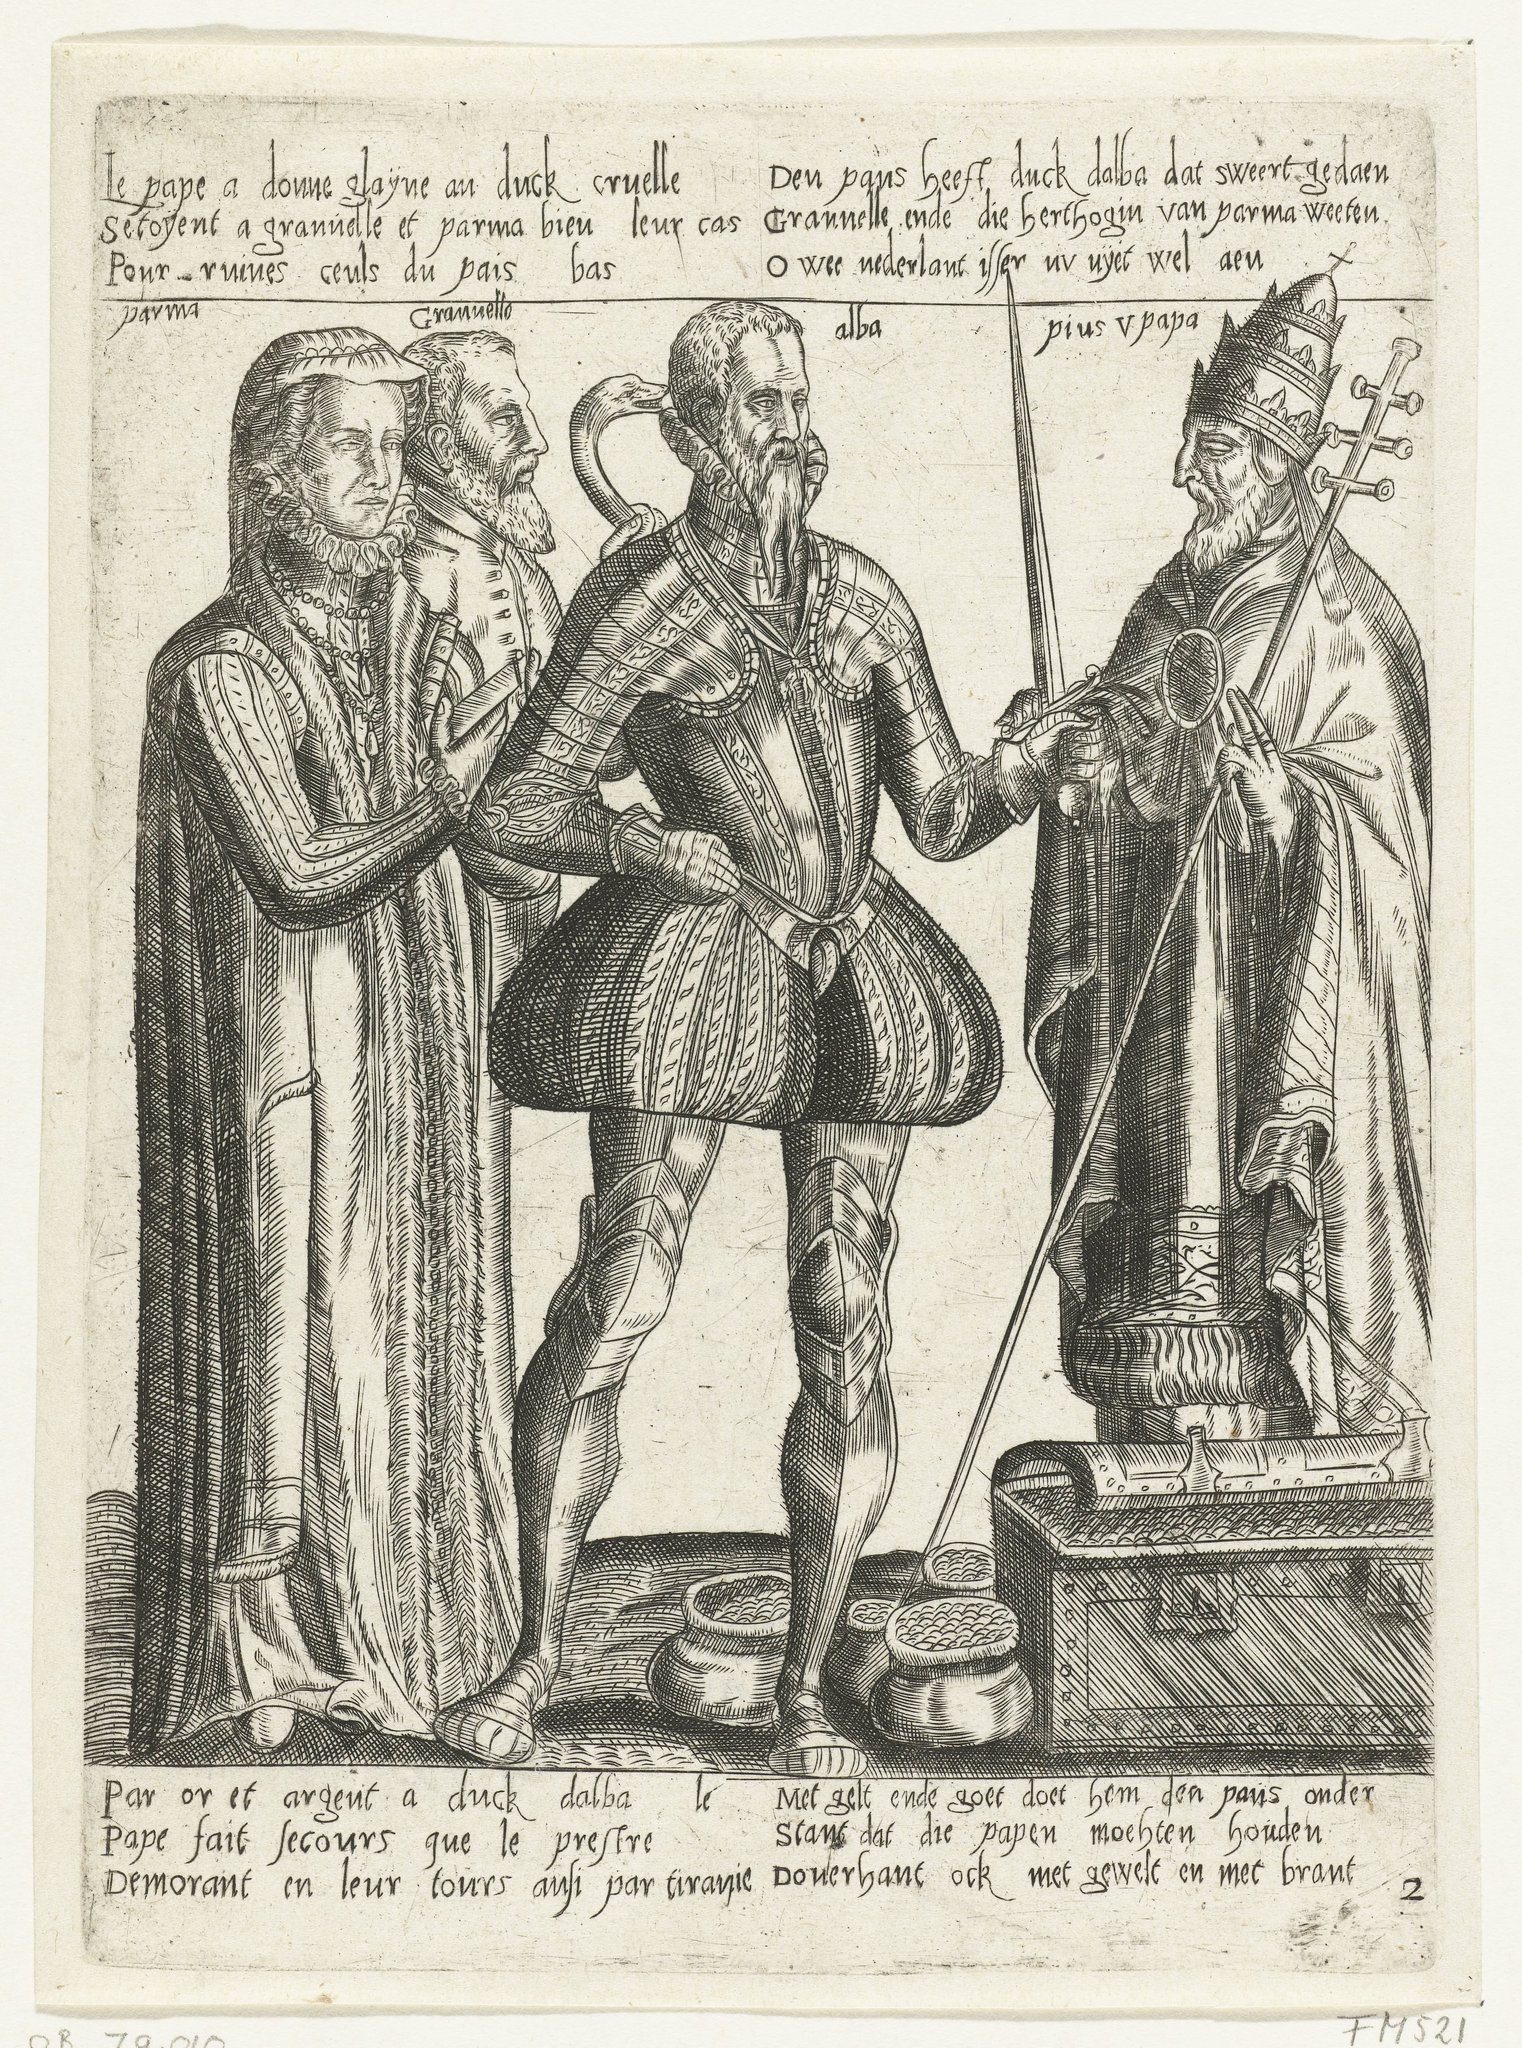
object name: print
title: Alva's opdracht in de Nederlanden en de gevolgen van zijn tirannie, 1572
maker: Anonymous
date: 1572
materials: paper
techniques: engraving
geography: low countries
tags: rome, pius v, fernando álvarez de toledo (3rd duke of alba), antoine perrenot de granvelle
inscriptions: inscription: ‘Den paus heeft duck dalba dat sweert gedaen Granvelle ende die herthogin van parma weeten O wee nederlant isser nu nyet wal aen Met gelt ende goet doet hem den paus onder Stant dat die papen moehten houden Doverhant ock met gewelt en met brant’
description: Margaretha van Parma, Granvelle en de paus steunen Alva's missie. Alva ontvangt van paus Pius V een zwaard en geld. Granvelle houdt een slang bij Alva's oor. Zowel boven als onder de voorstelling 2 verzen van 3 regels in het Nederlands en Frans. Genummerd: 2.